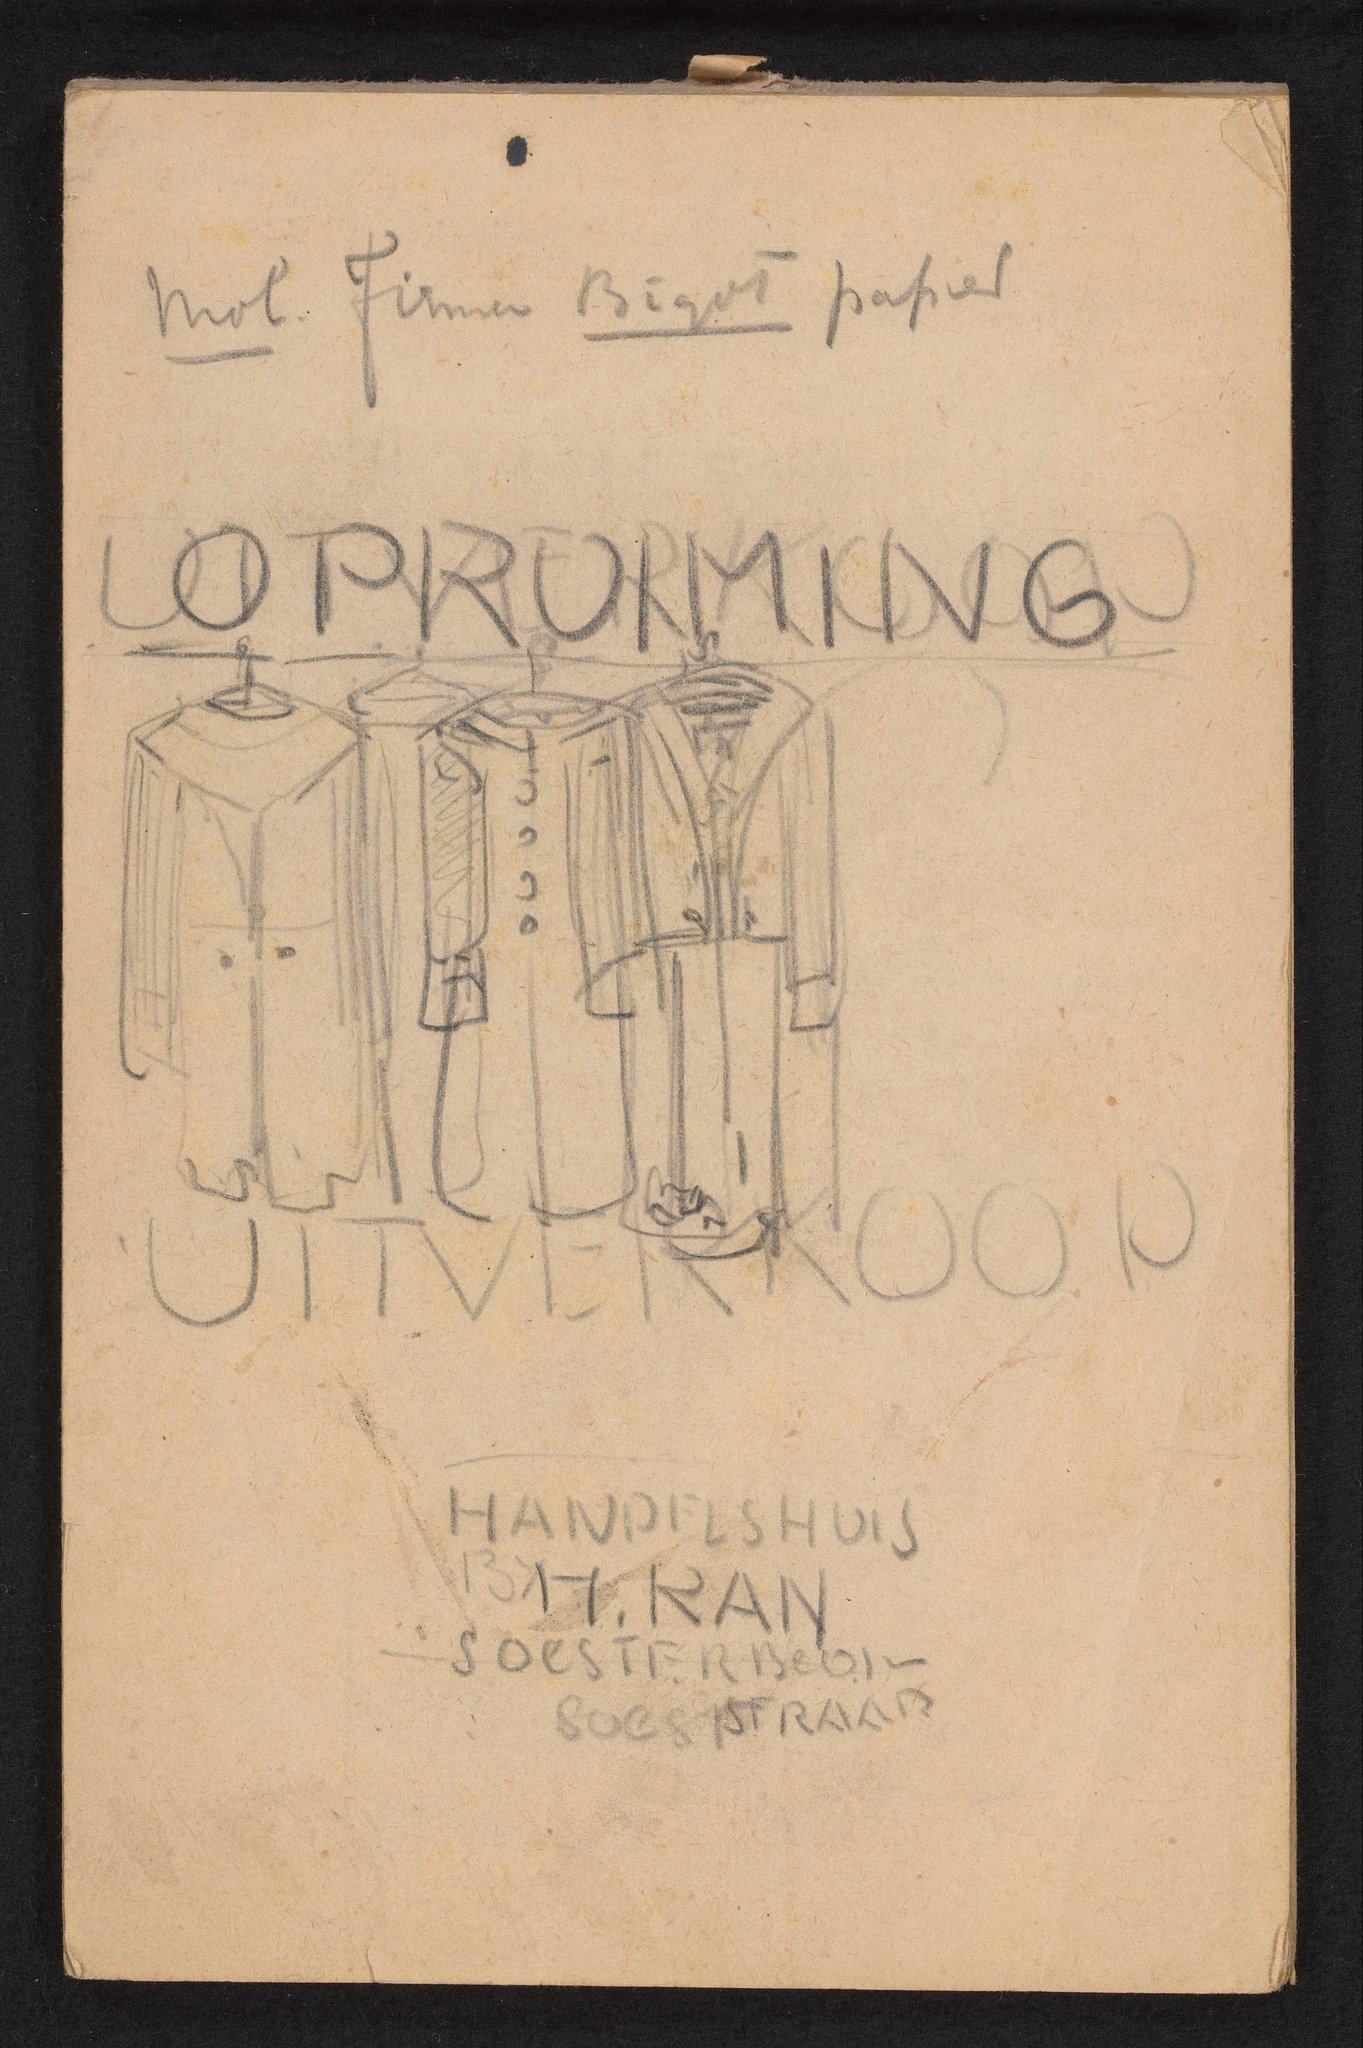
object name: sketchbook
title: Schetsboek met 11 bladen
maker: reinier willem petrus de vries (1874-1953)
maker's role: draughtsman, print maker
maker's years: 1874-1953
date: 1884-1952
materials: chalk, paper, pencil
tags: fashion, clothing, landscapes, dog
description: Schetsboek bestaande uit 11 bladen met ontwerpen voor advertenties voor verschillende producten. Tevens studies van honden en landschappen.